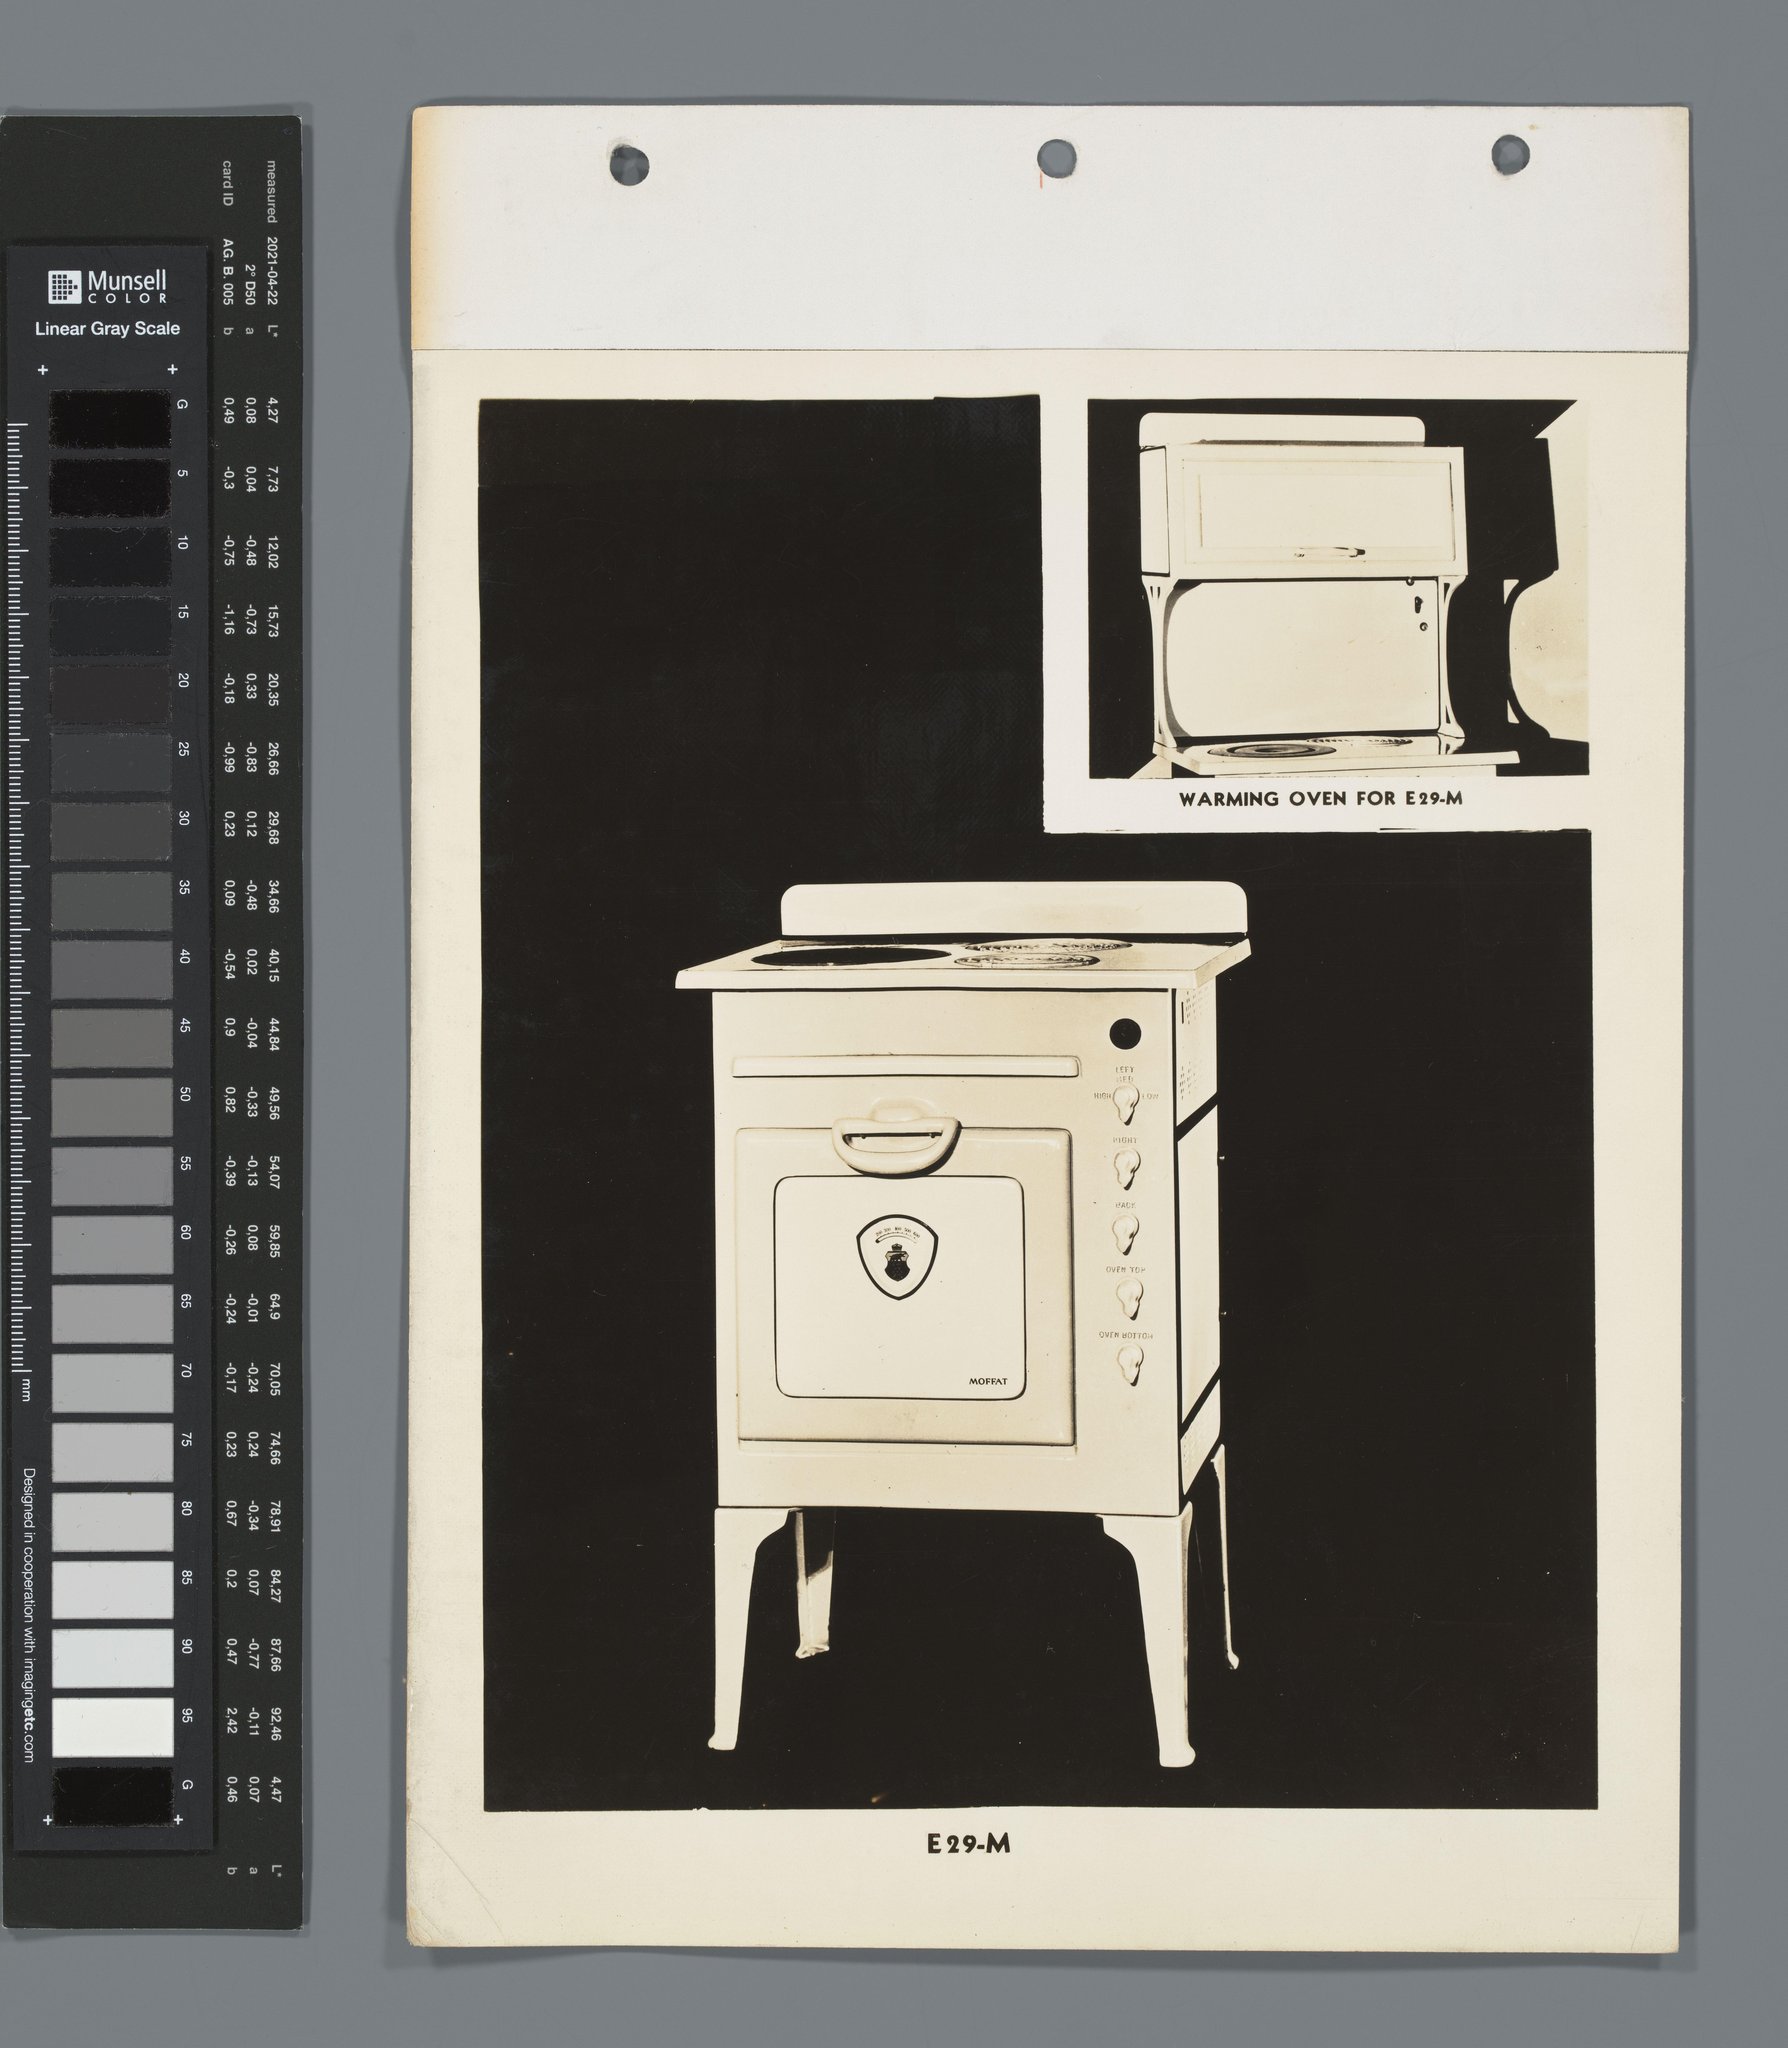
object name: photograph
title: Foto van Moffat ovens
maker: Anonymous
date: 1935-1940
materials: paper, photographic support, textile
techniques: gelatin silver print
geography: canada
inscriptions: inscription: ‘E 29-M’, inscription: ‘WARMING OVEN FOR E 29-M’